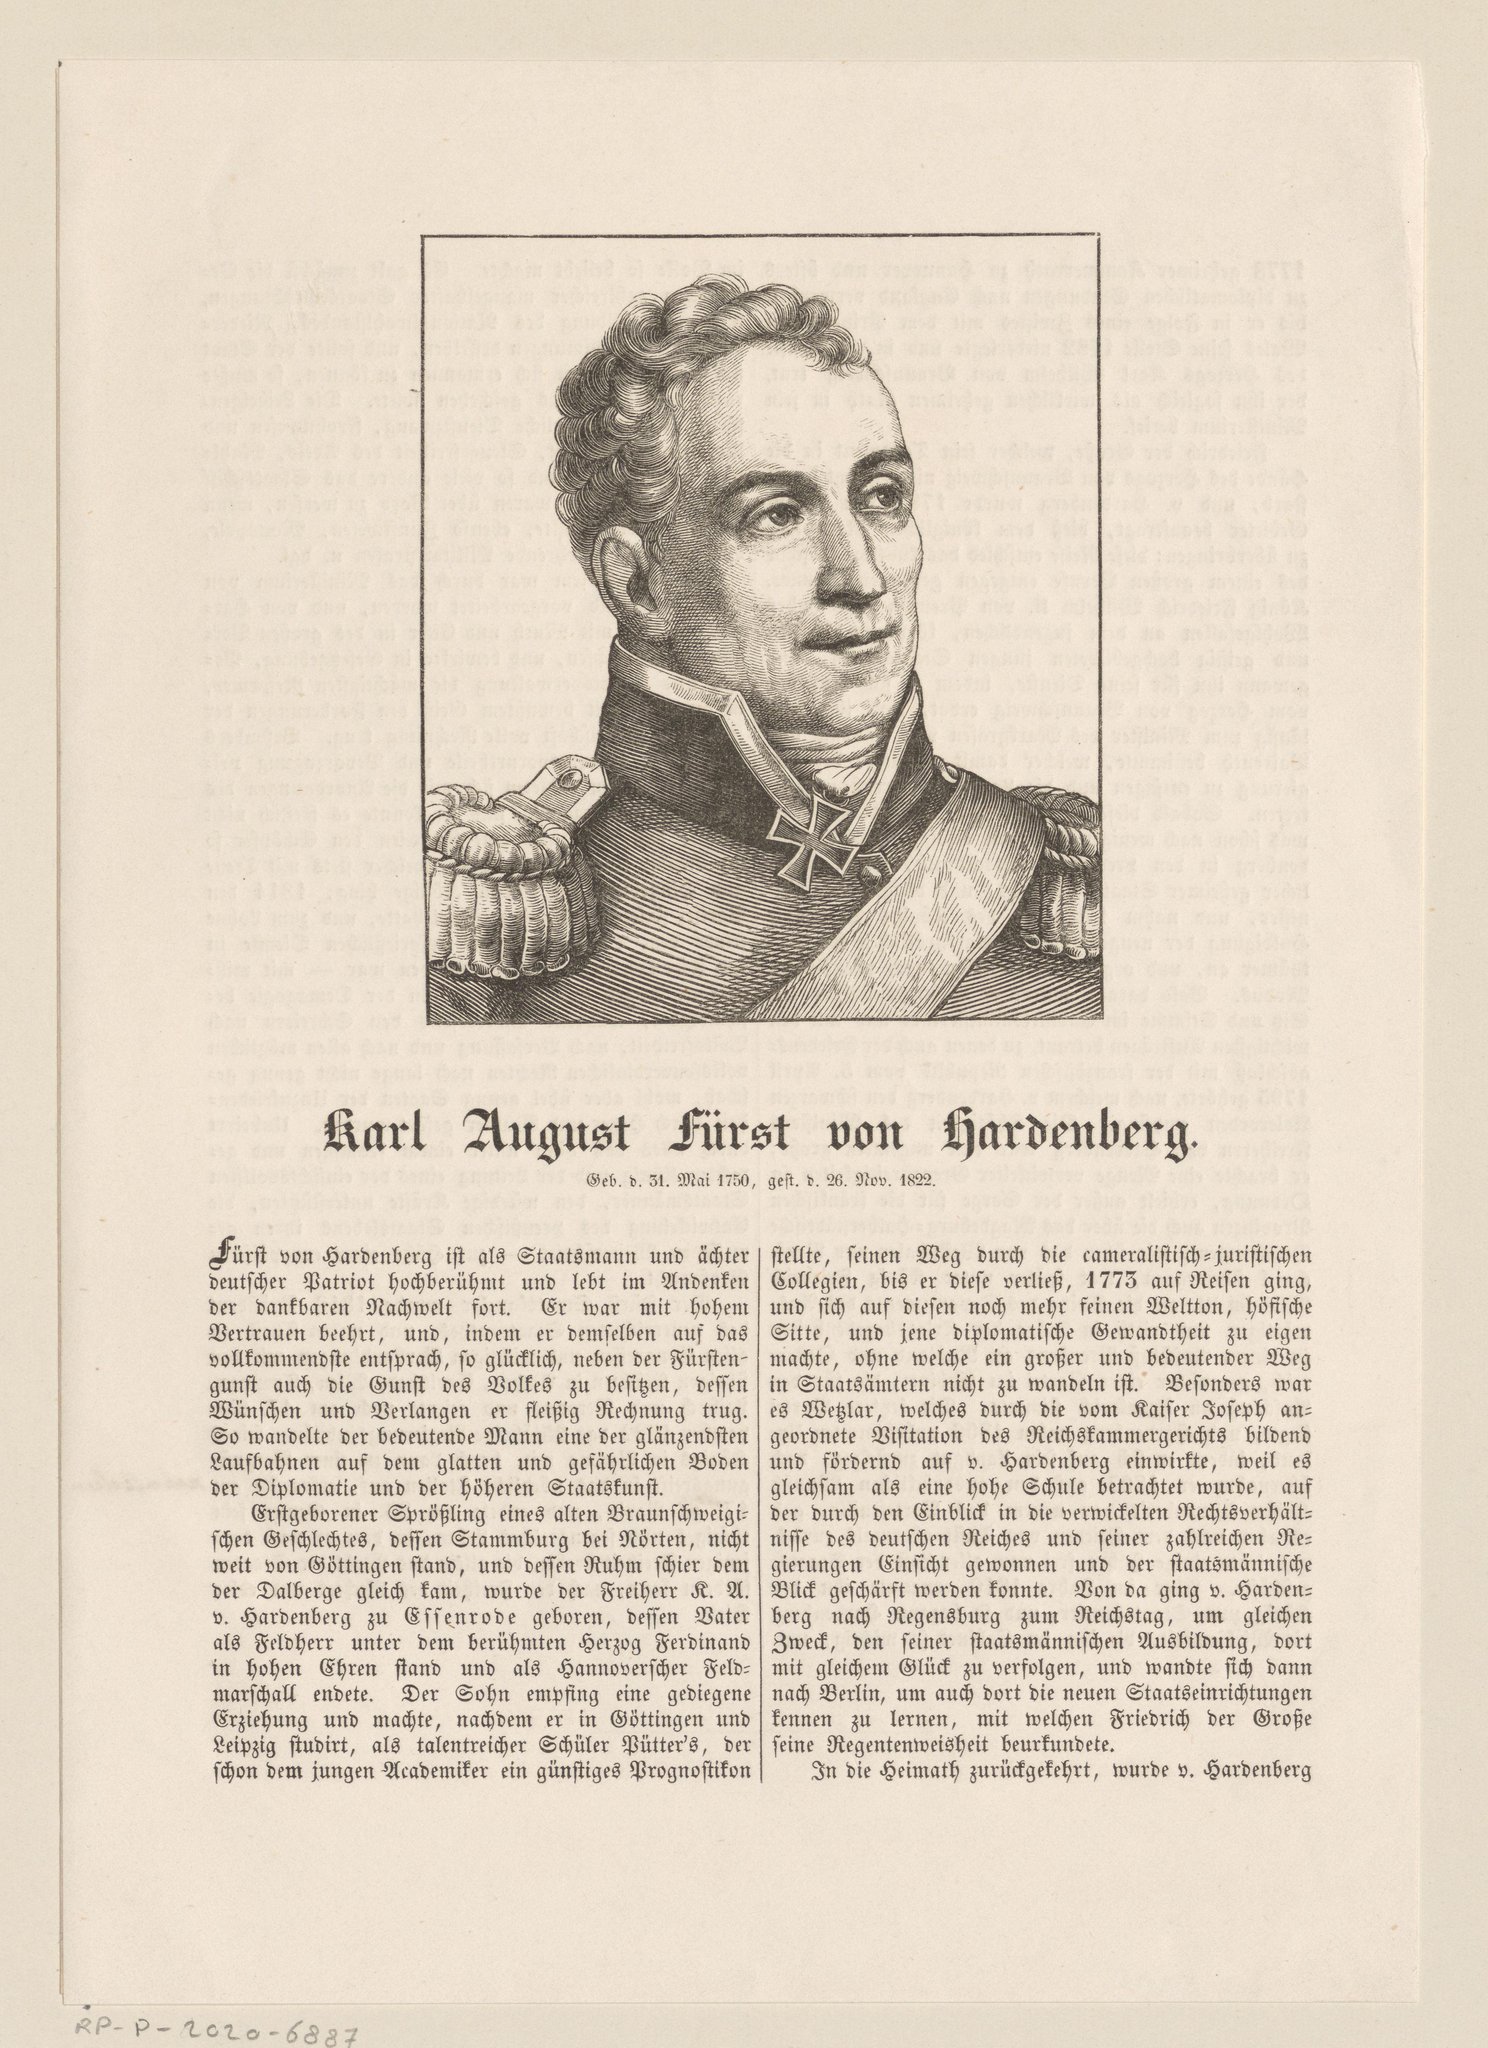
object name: print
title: Portret van Karl August von Hardenberg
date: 1854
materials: paper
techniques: letterpress printing, engraving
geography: leipzig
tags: historical persons, politician, e.g. party leader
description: Prent uit: Bechstein, Ludwig. Zweihundert deutsche Männer in Bildnissen und Lebensbeschreibungen. Leipzig: Georg Wigand, 1854.